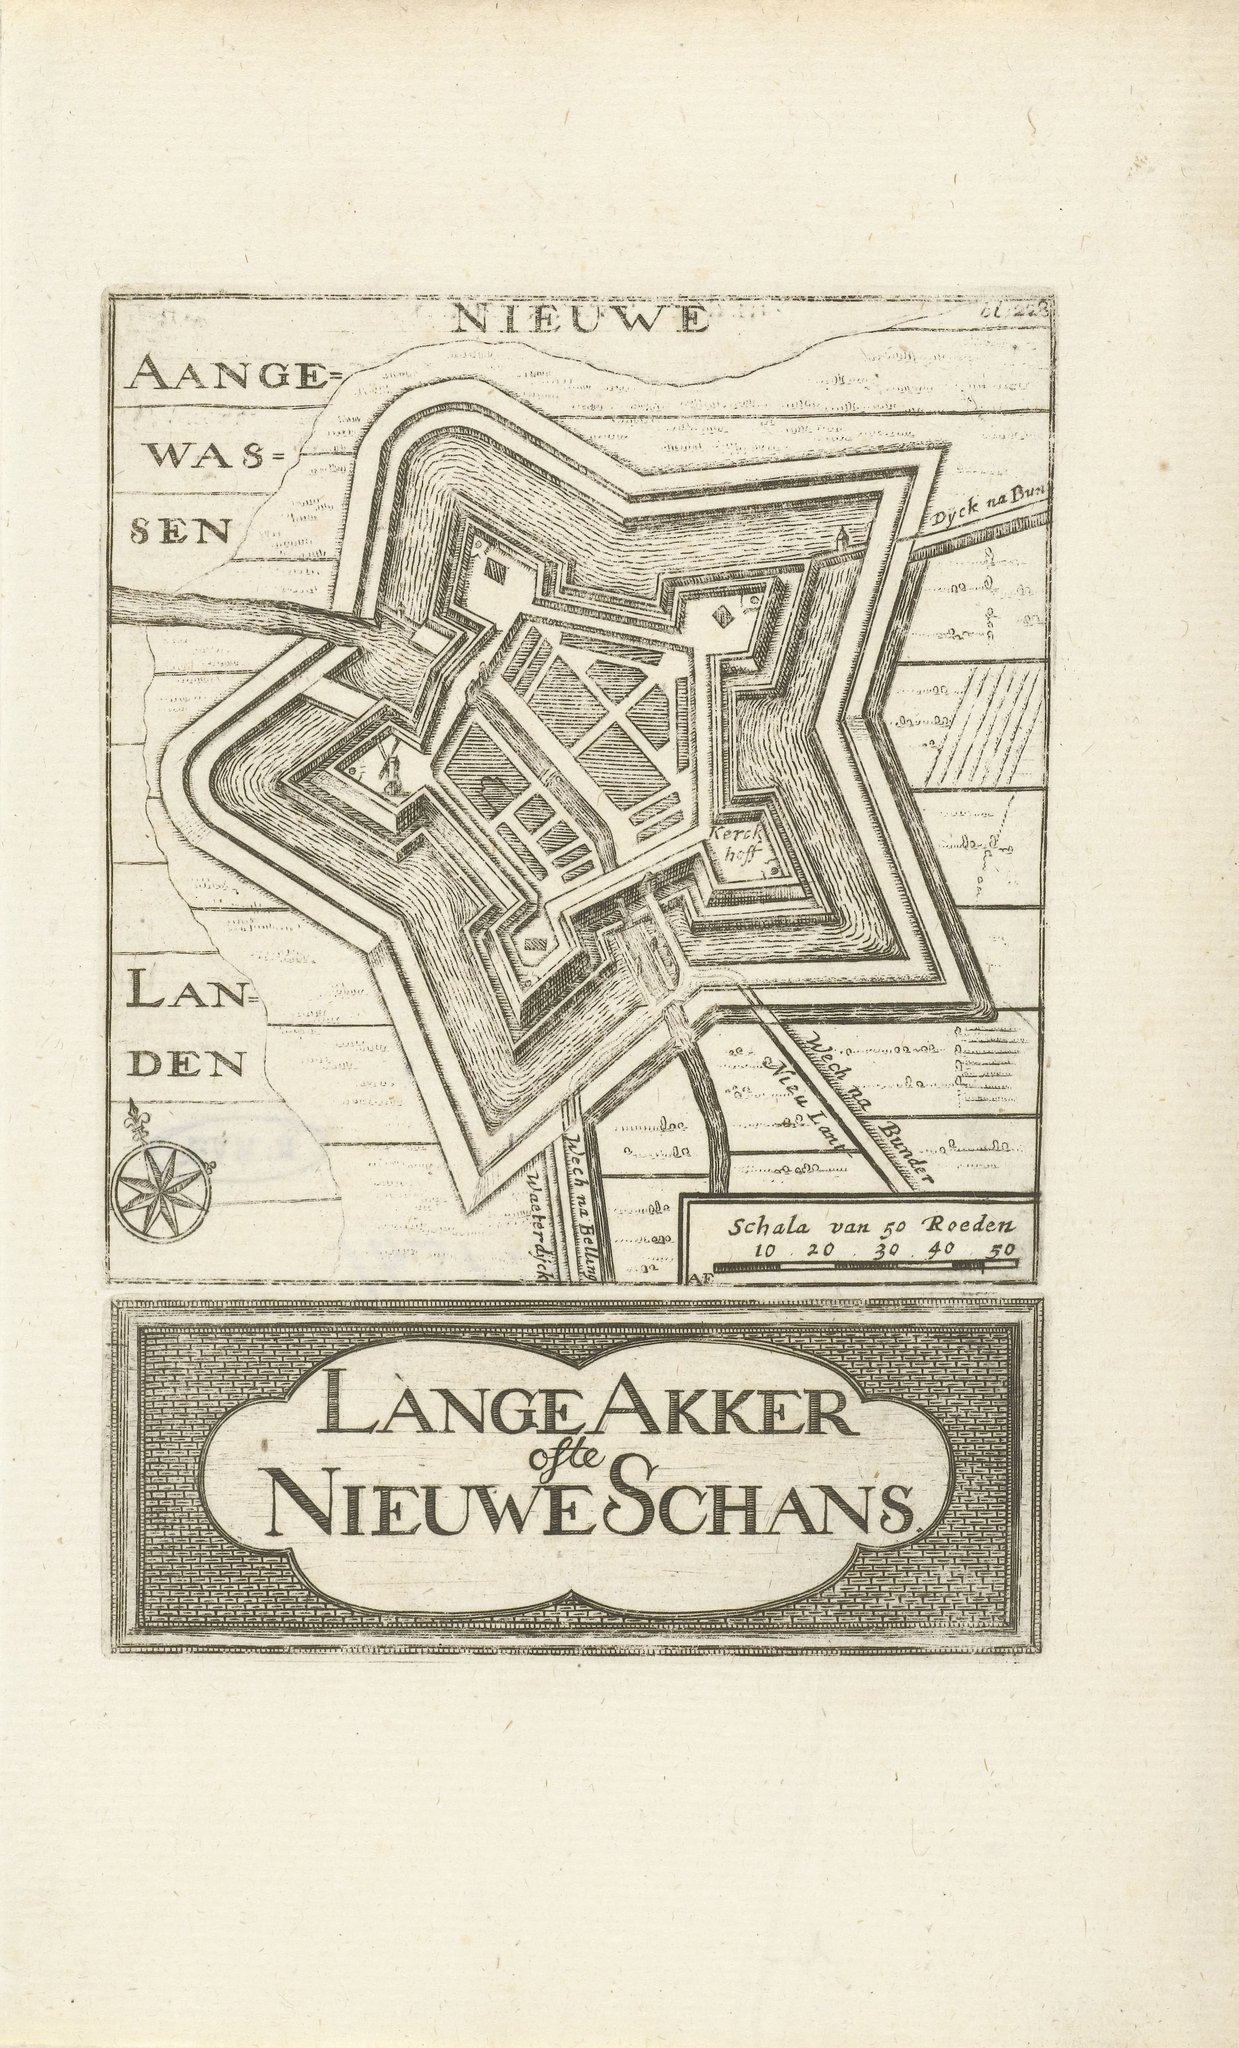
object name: print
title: Lange Akker ofte Nieuwe Schans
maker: hendrik hofsnider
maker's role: print maker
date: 1743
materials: paper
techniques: etching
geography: groningen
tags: maps, atlases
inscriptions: collector's mark: Lugt 2760, collector's mark: Lugt 2228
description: Twee afdrukken op één blad: Bovenaan een afdruk met een voorstelling van een kaart van Nieuweschans en daaronder een afdruk met de titel in een cartouche. In de bovenste afdruk rechtsonder een schaal en rechtsboven: bl. 228.